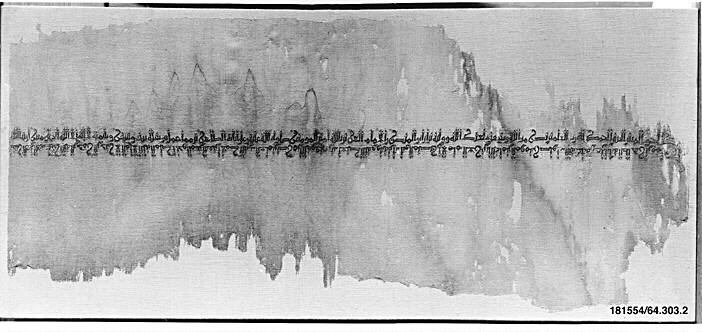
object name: textile fragment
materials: linen, silk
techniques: weave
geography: egypt